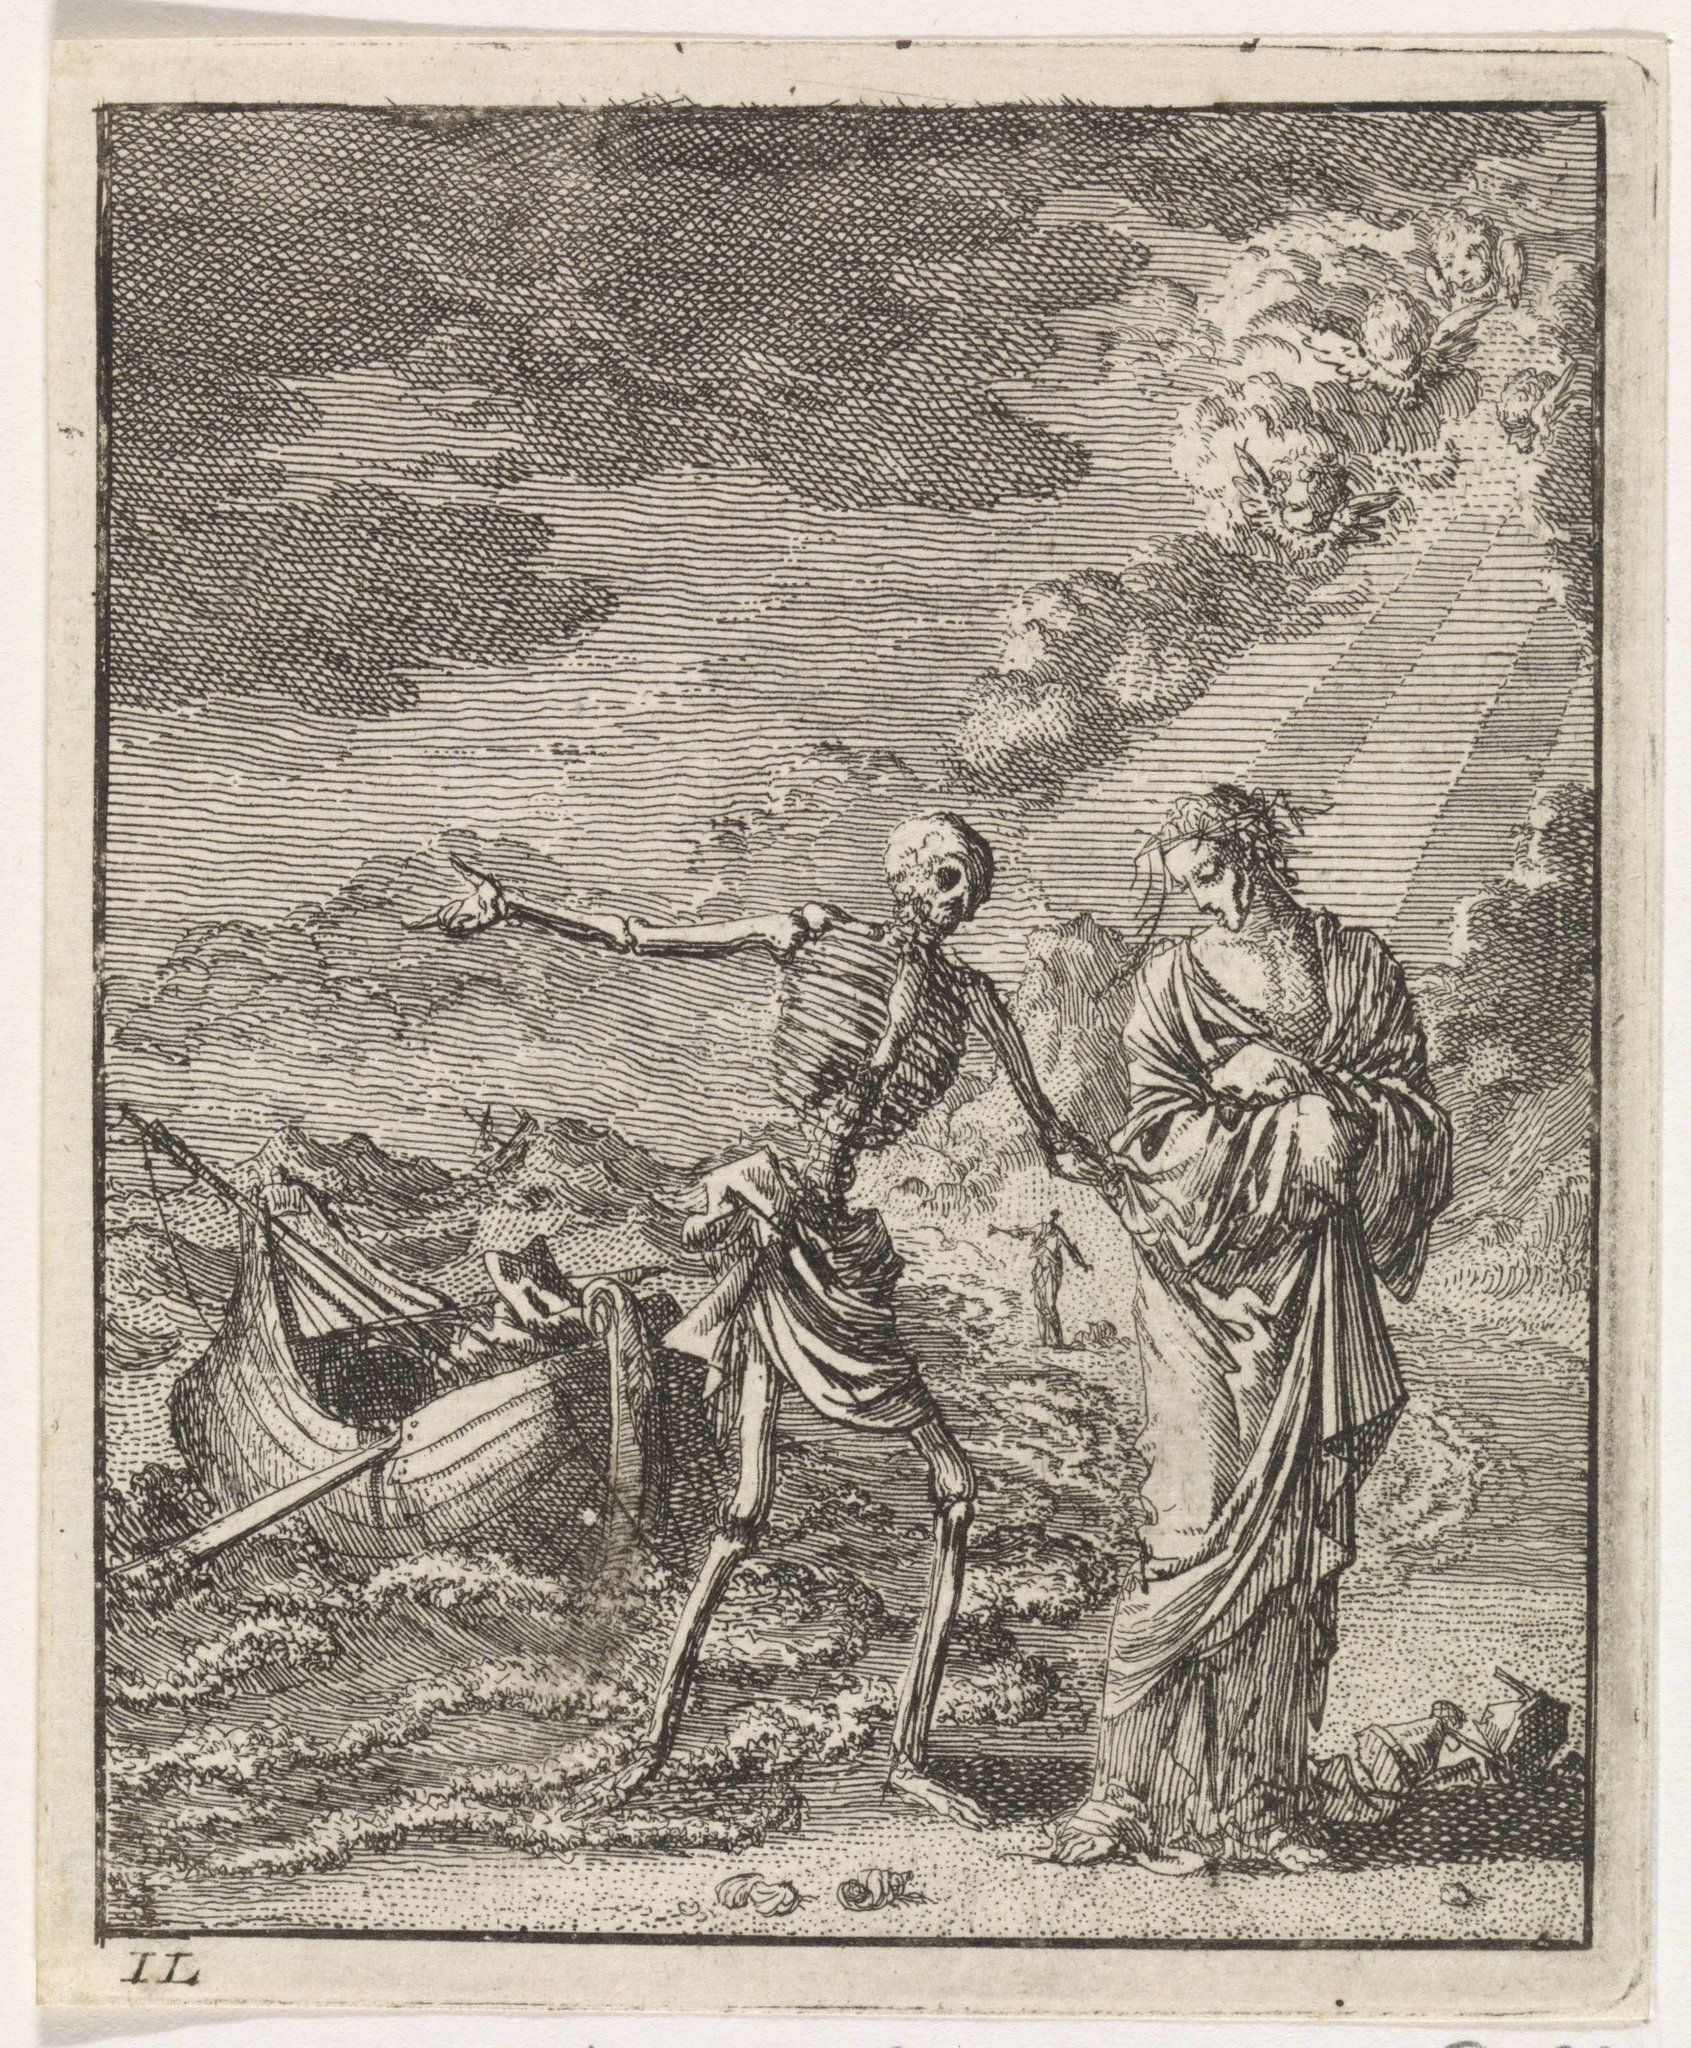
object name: print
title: De Dood probeert een man mee in zijn schip te krijgen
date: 1704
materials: paper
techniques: etching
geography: amsterdam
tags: death as skeleton, ships (in general), beach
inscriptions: collector's mark: Lugt 2228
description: Illustratie uit: Luyken, Jan. De zedelyke en stichtelyke gezangen. Amsterdam: Wed. Pieter Arentsz (II) en Cornelis van der Sys, 1704, p. 181.